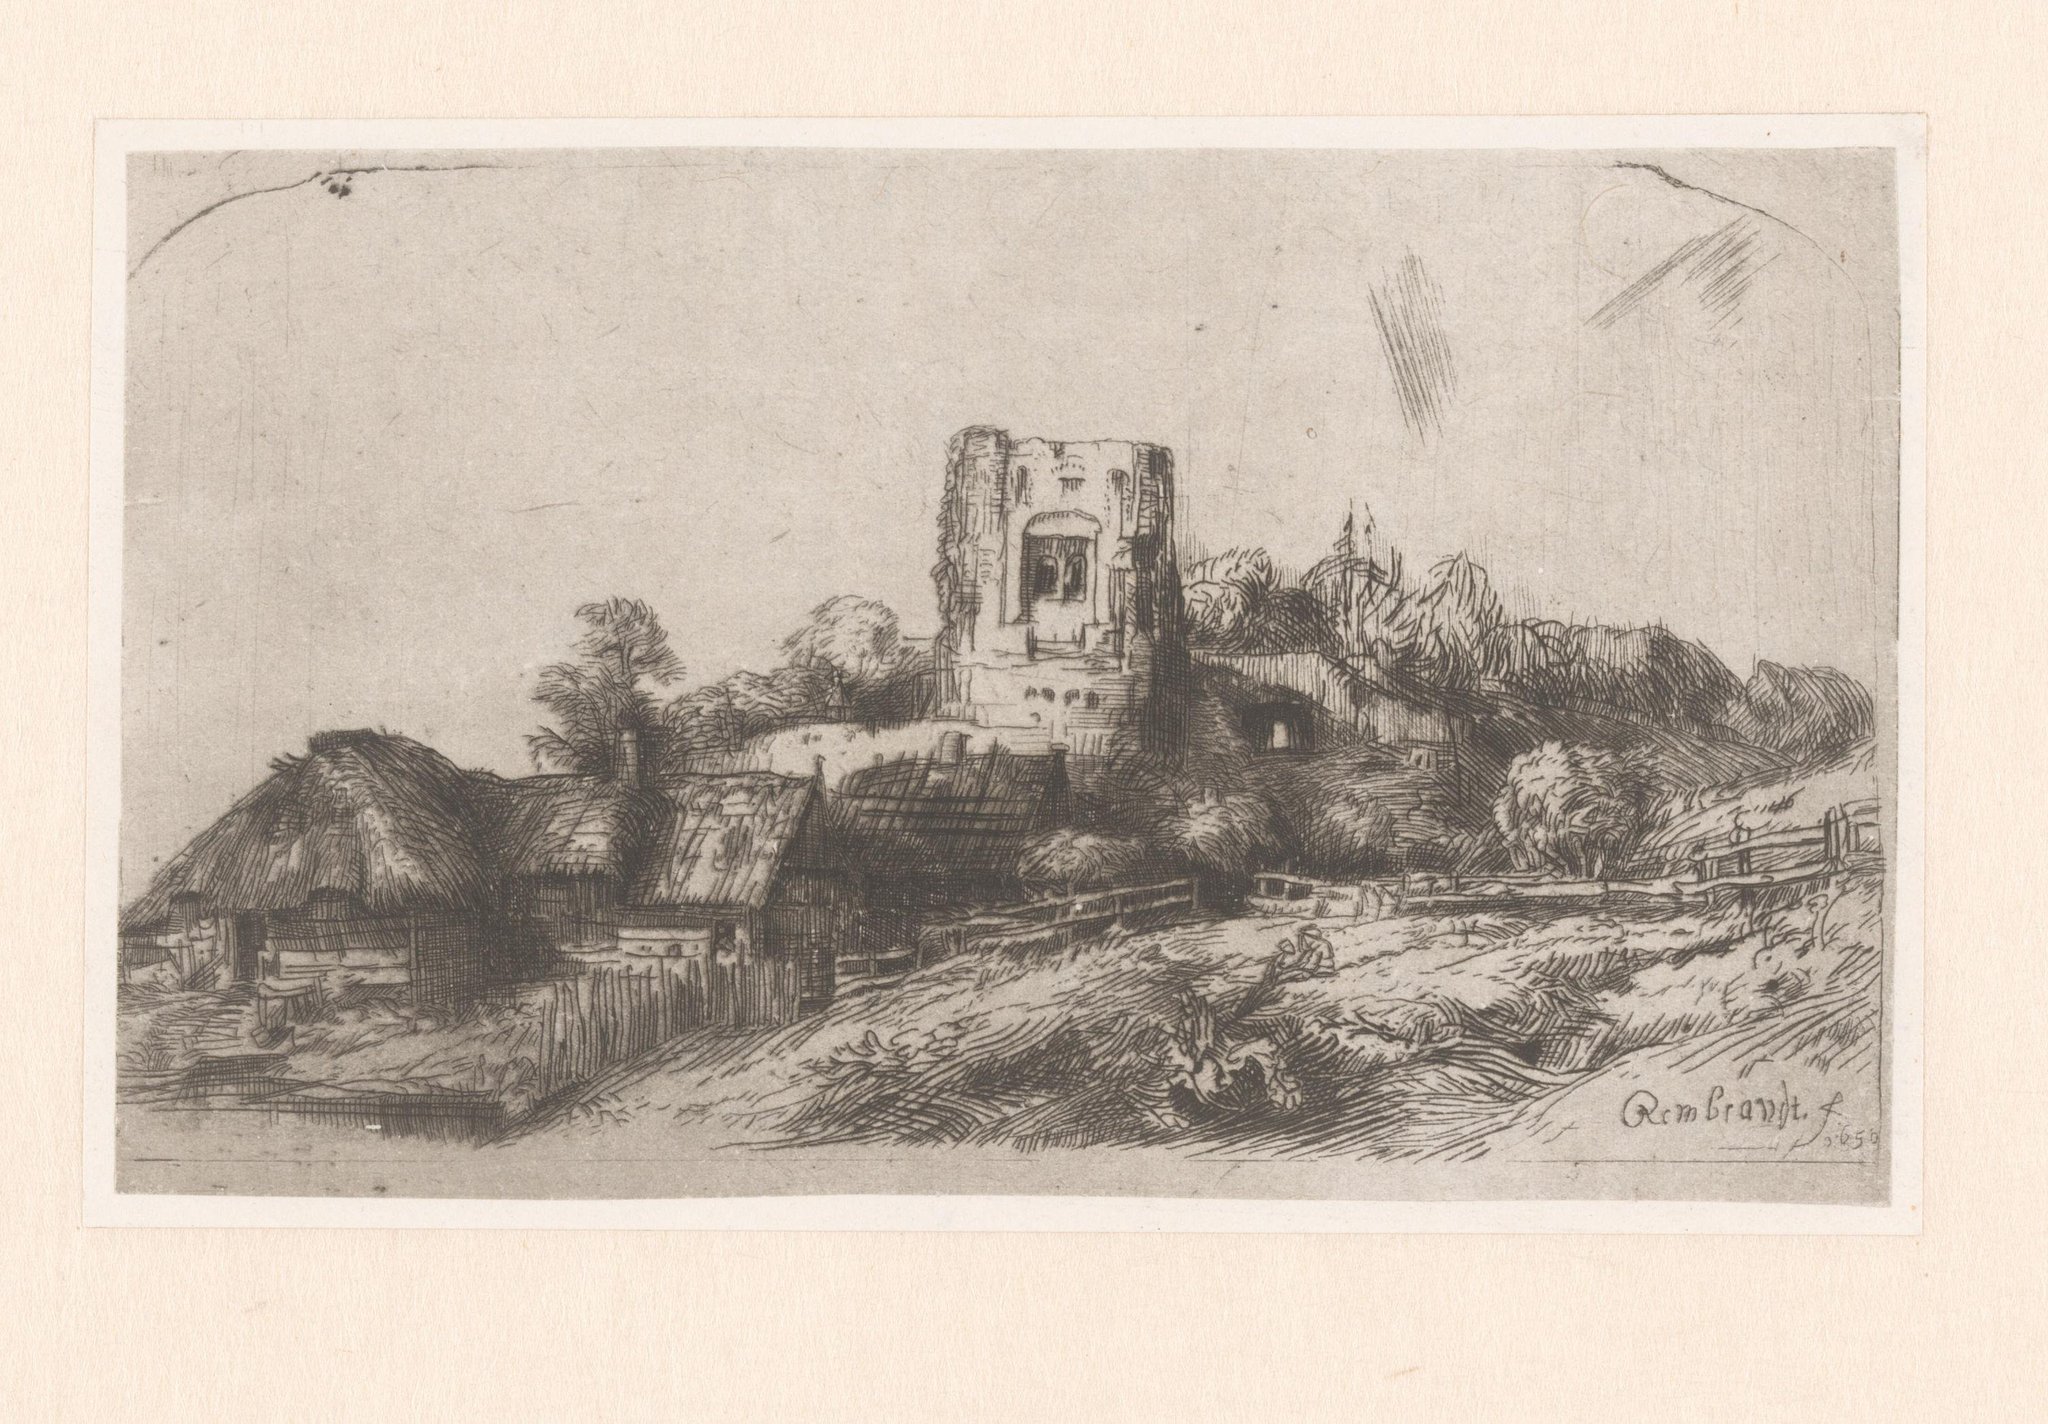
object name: print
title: Landscape with a square tower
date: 1841-1911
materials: paper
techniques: etching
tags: city-view, and landscape with man-made constructions, hut, cabin, lodge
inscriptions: collector's mark: Lugt 2228, collector's mark: Lugt 2760